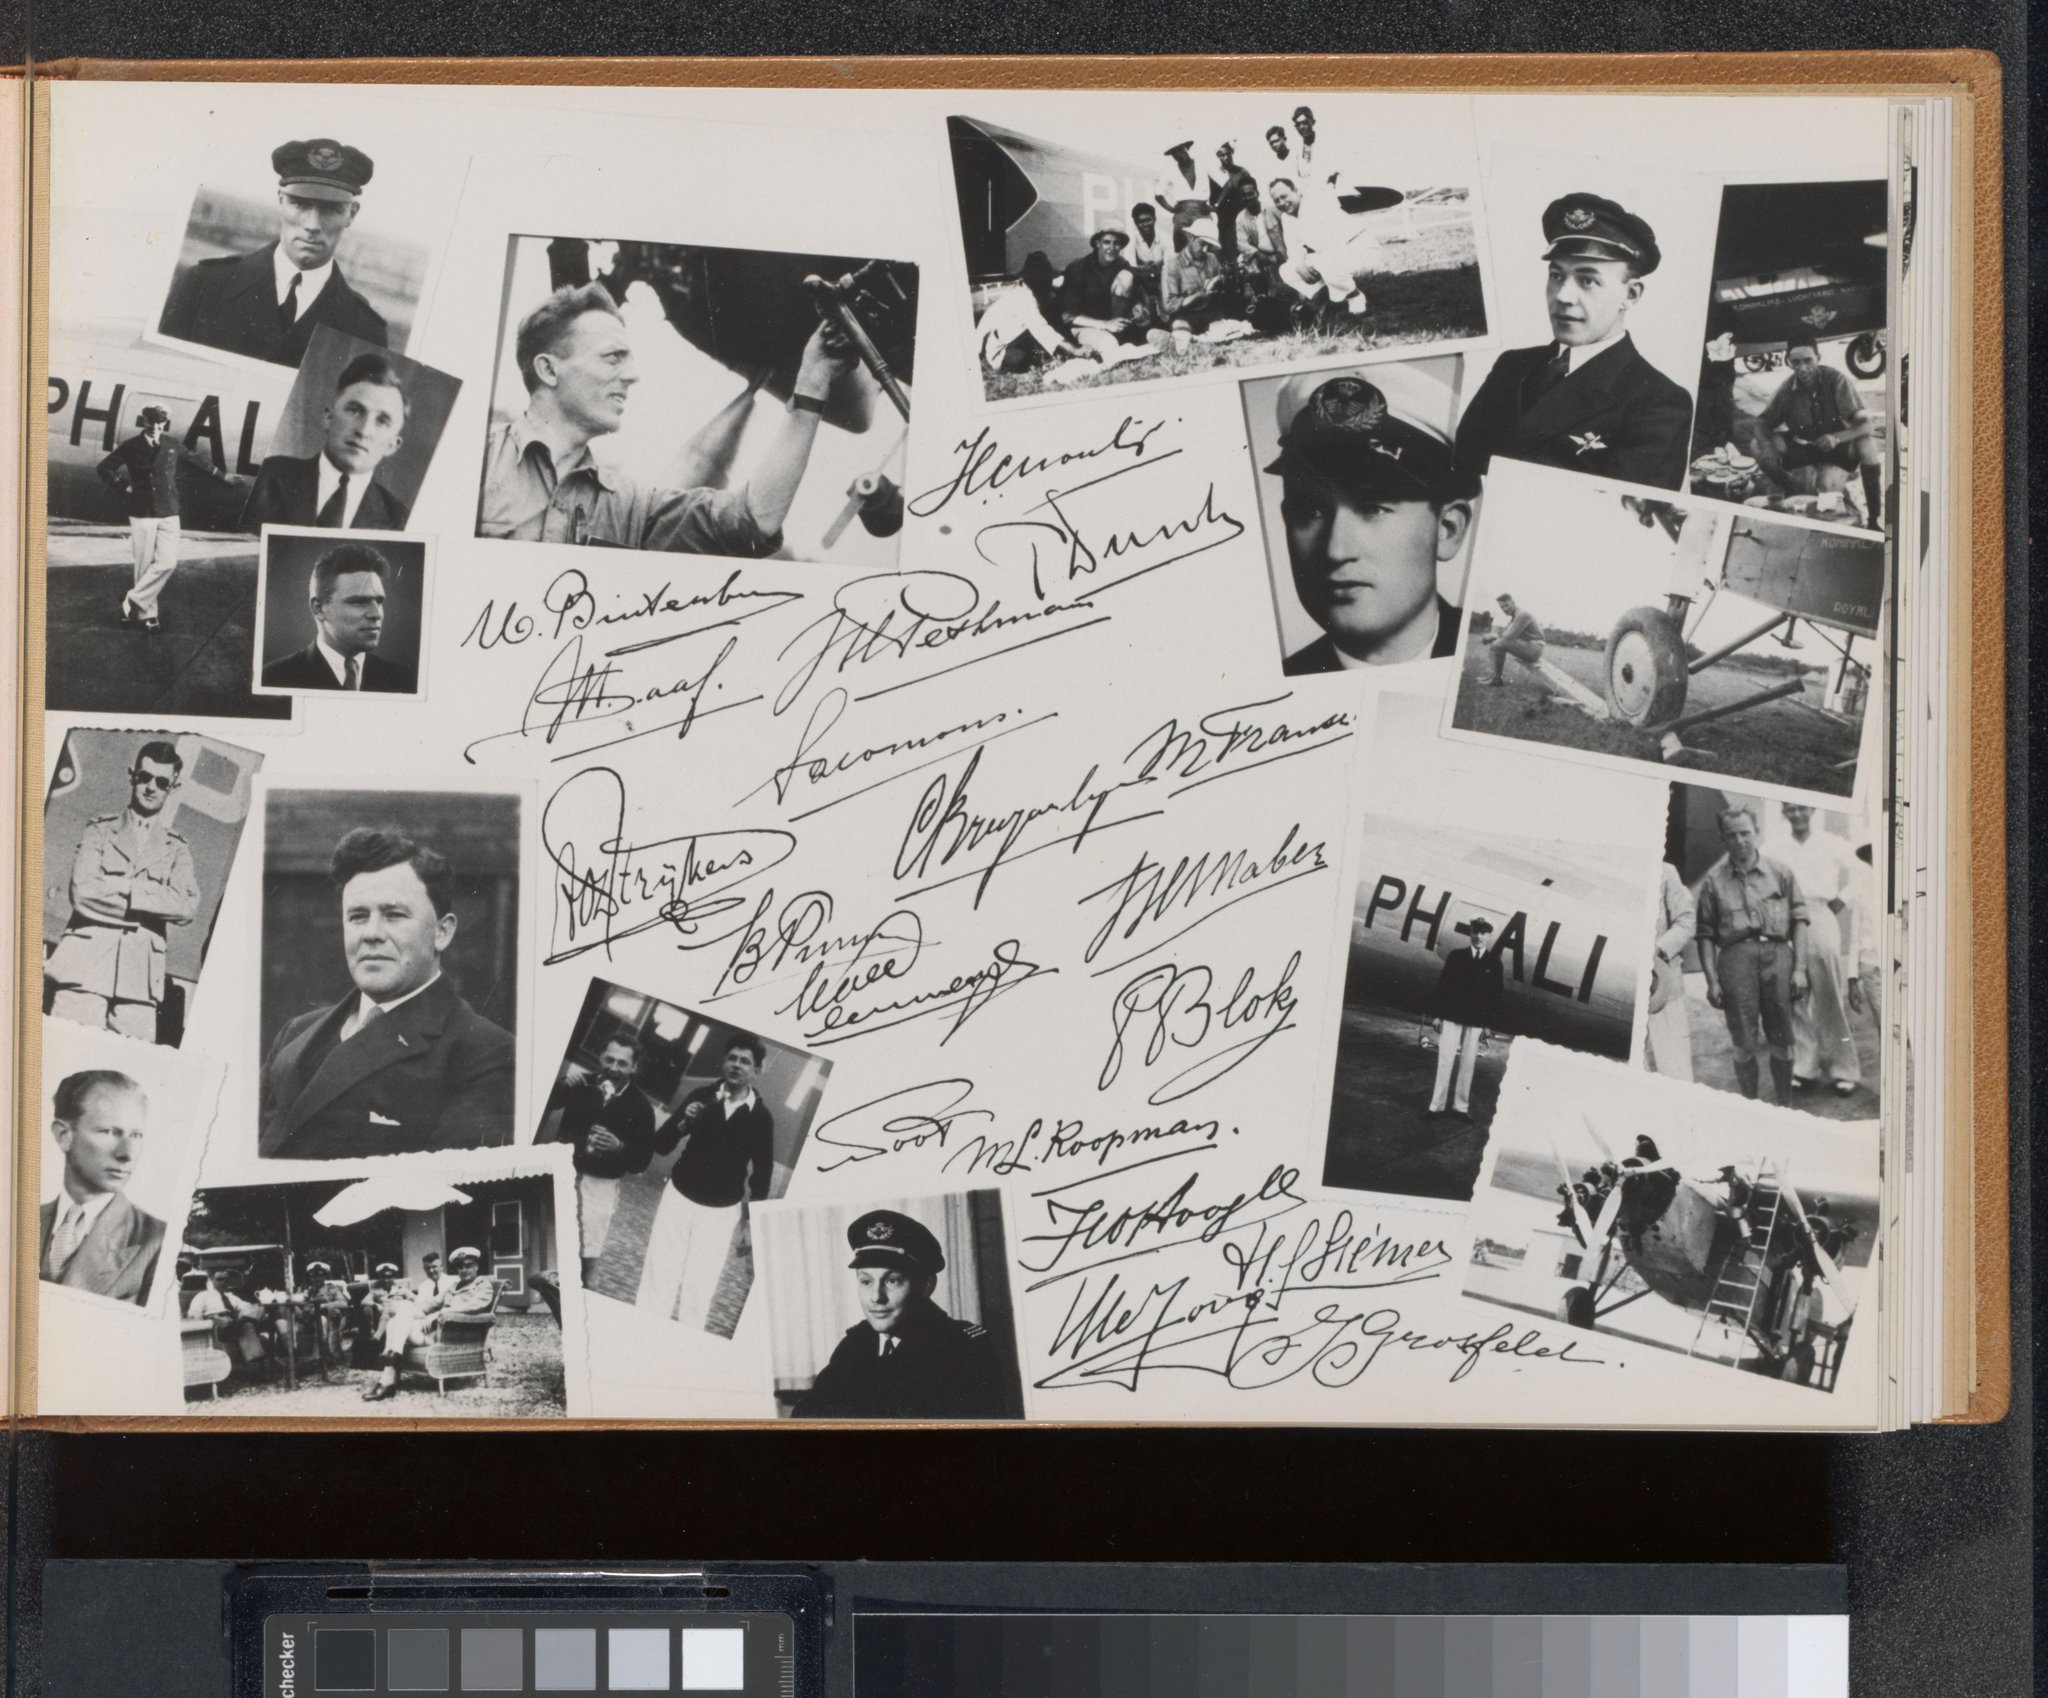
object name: photomontage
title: KLM-personeel en handtekeningen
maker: Anonymous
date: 1949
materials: cardboard, paper, photographic support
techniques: gelatin silver print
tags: airborne traffic, aviation, pilot, flight crew, travelling; tourism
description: Albumblad met een compositiefoto van KLM-werknemers en hun handtekeningen. Onderdeel van Herdenkingsalbum van de Indië-lijn van de KLM, deel II.